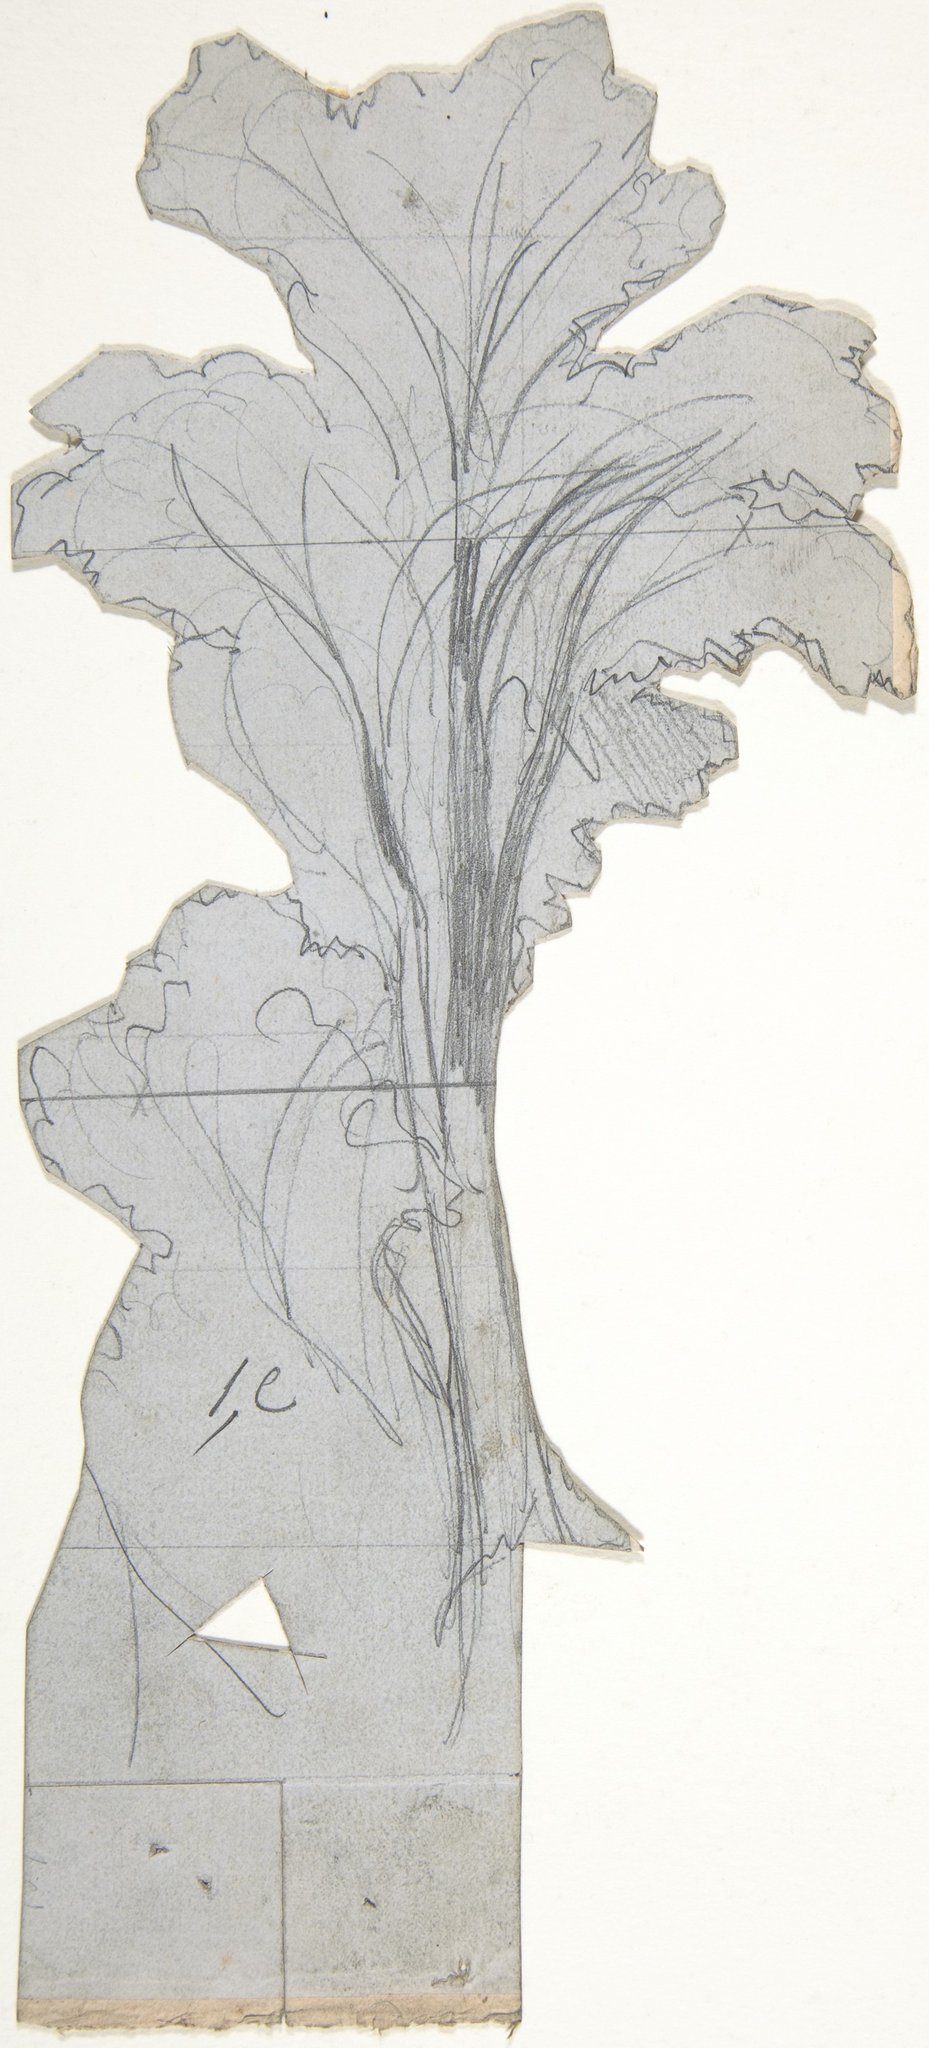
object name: drawing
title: Design for a Stage Set at the Opéra, Paris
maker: eugène cicéri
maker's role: artist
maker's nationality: french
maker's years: 1813-1890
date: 1830-1890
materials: graphite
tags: trees,stage design